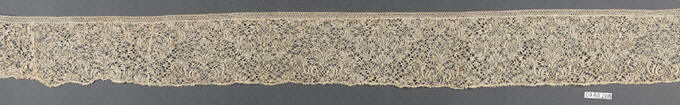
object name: strip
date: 1700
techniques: lace